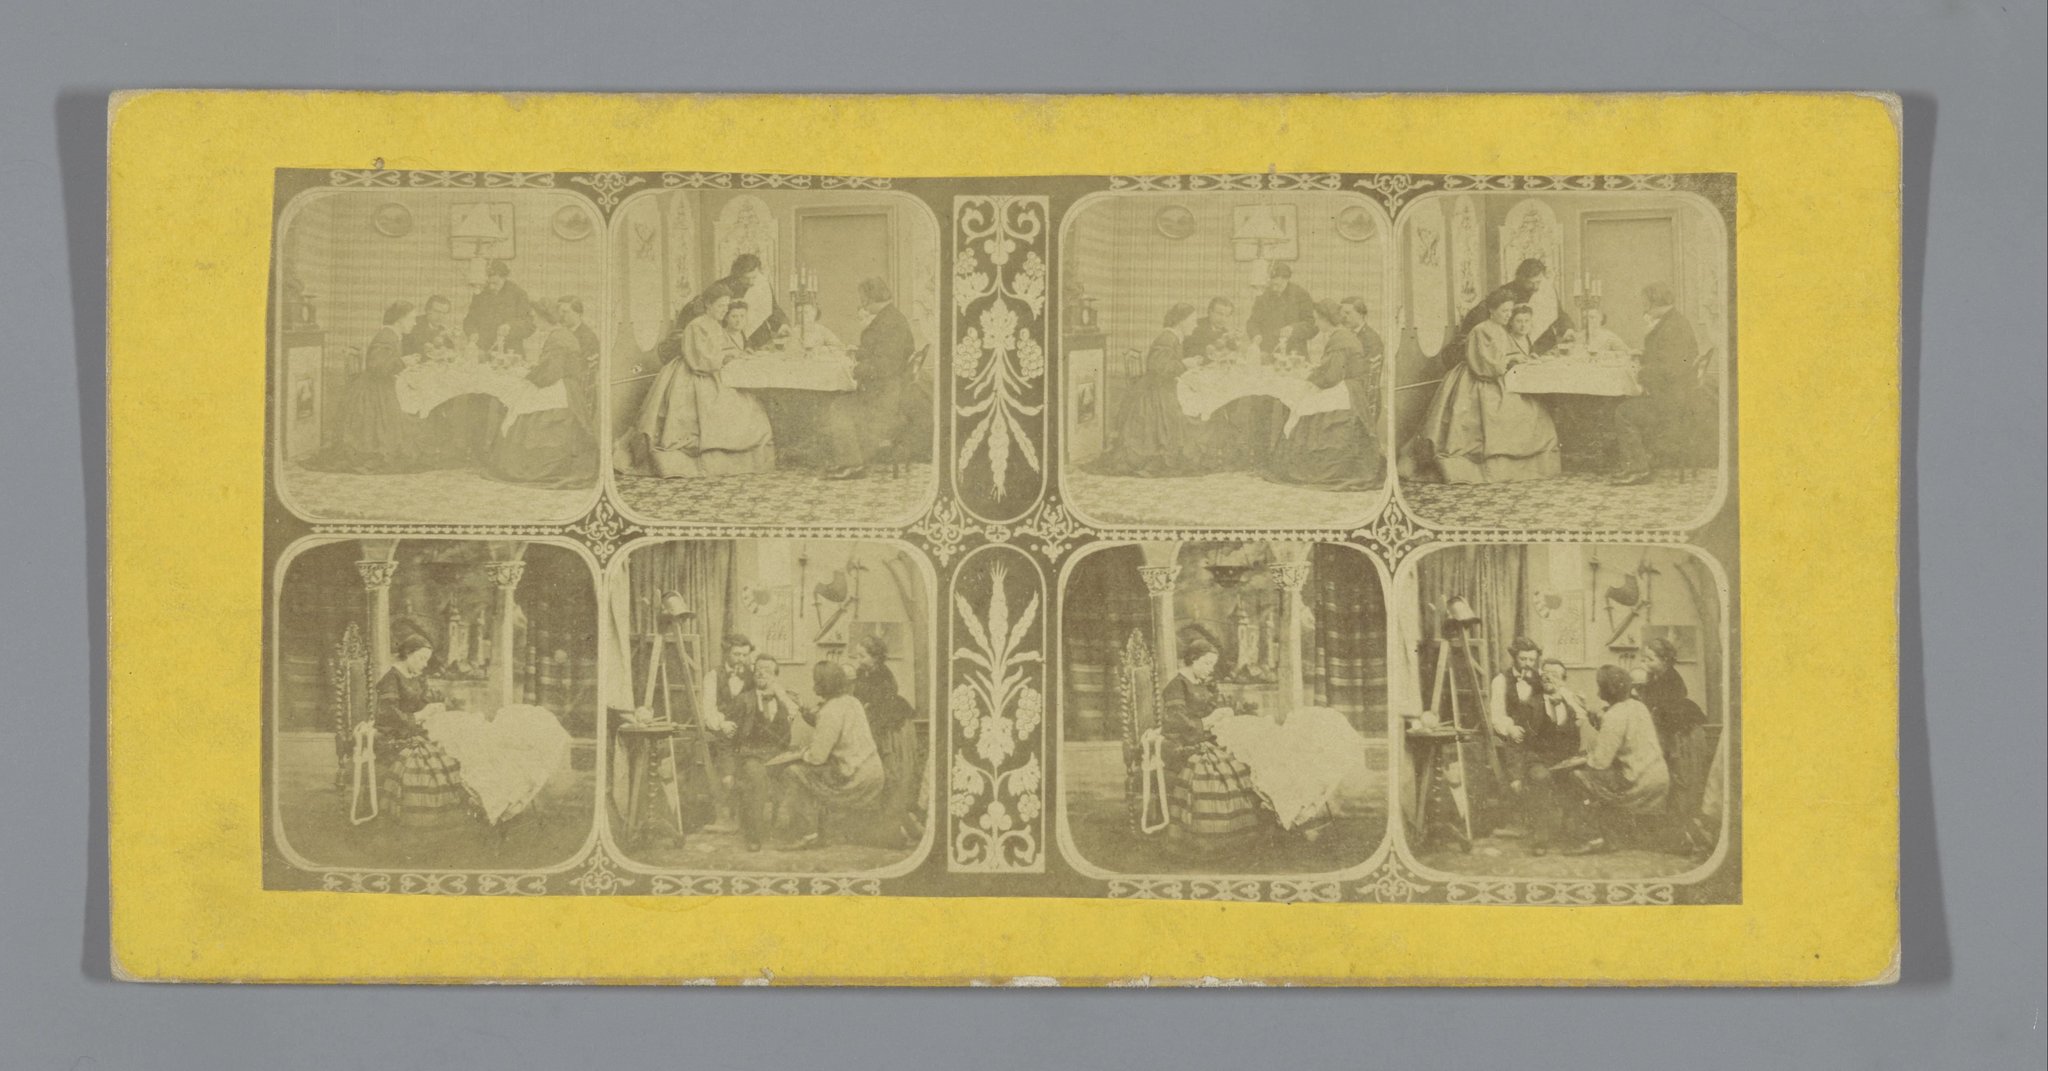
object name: stereograph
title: Stereofoto met vier kleinere stereo-opnamen van drie huiselijke taferelen en één opname in een atelier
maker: Anonymous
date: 1861-1870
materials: cardboard, paper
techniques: albumen print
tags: scenes ~ anonymous historical person(s)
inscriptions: inscription: ‘35 Ct va.’